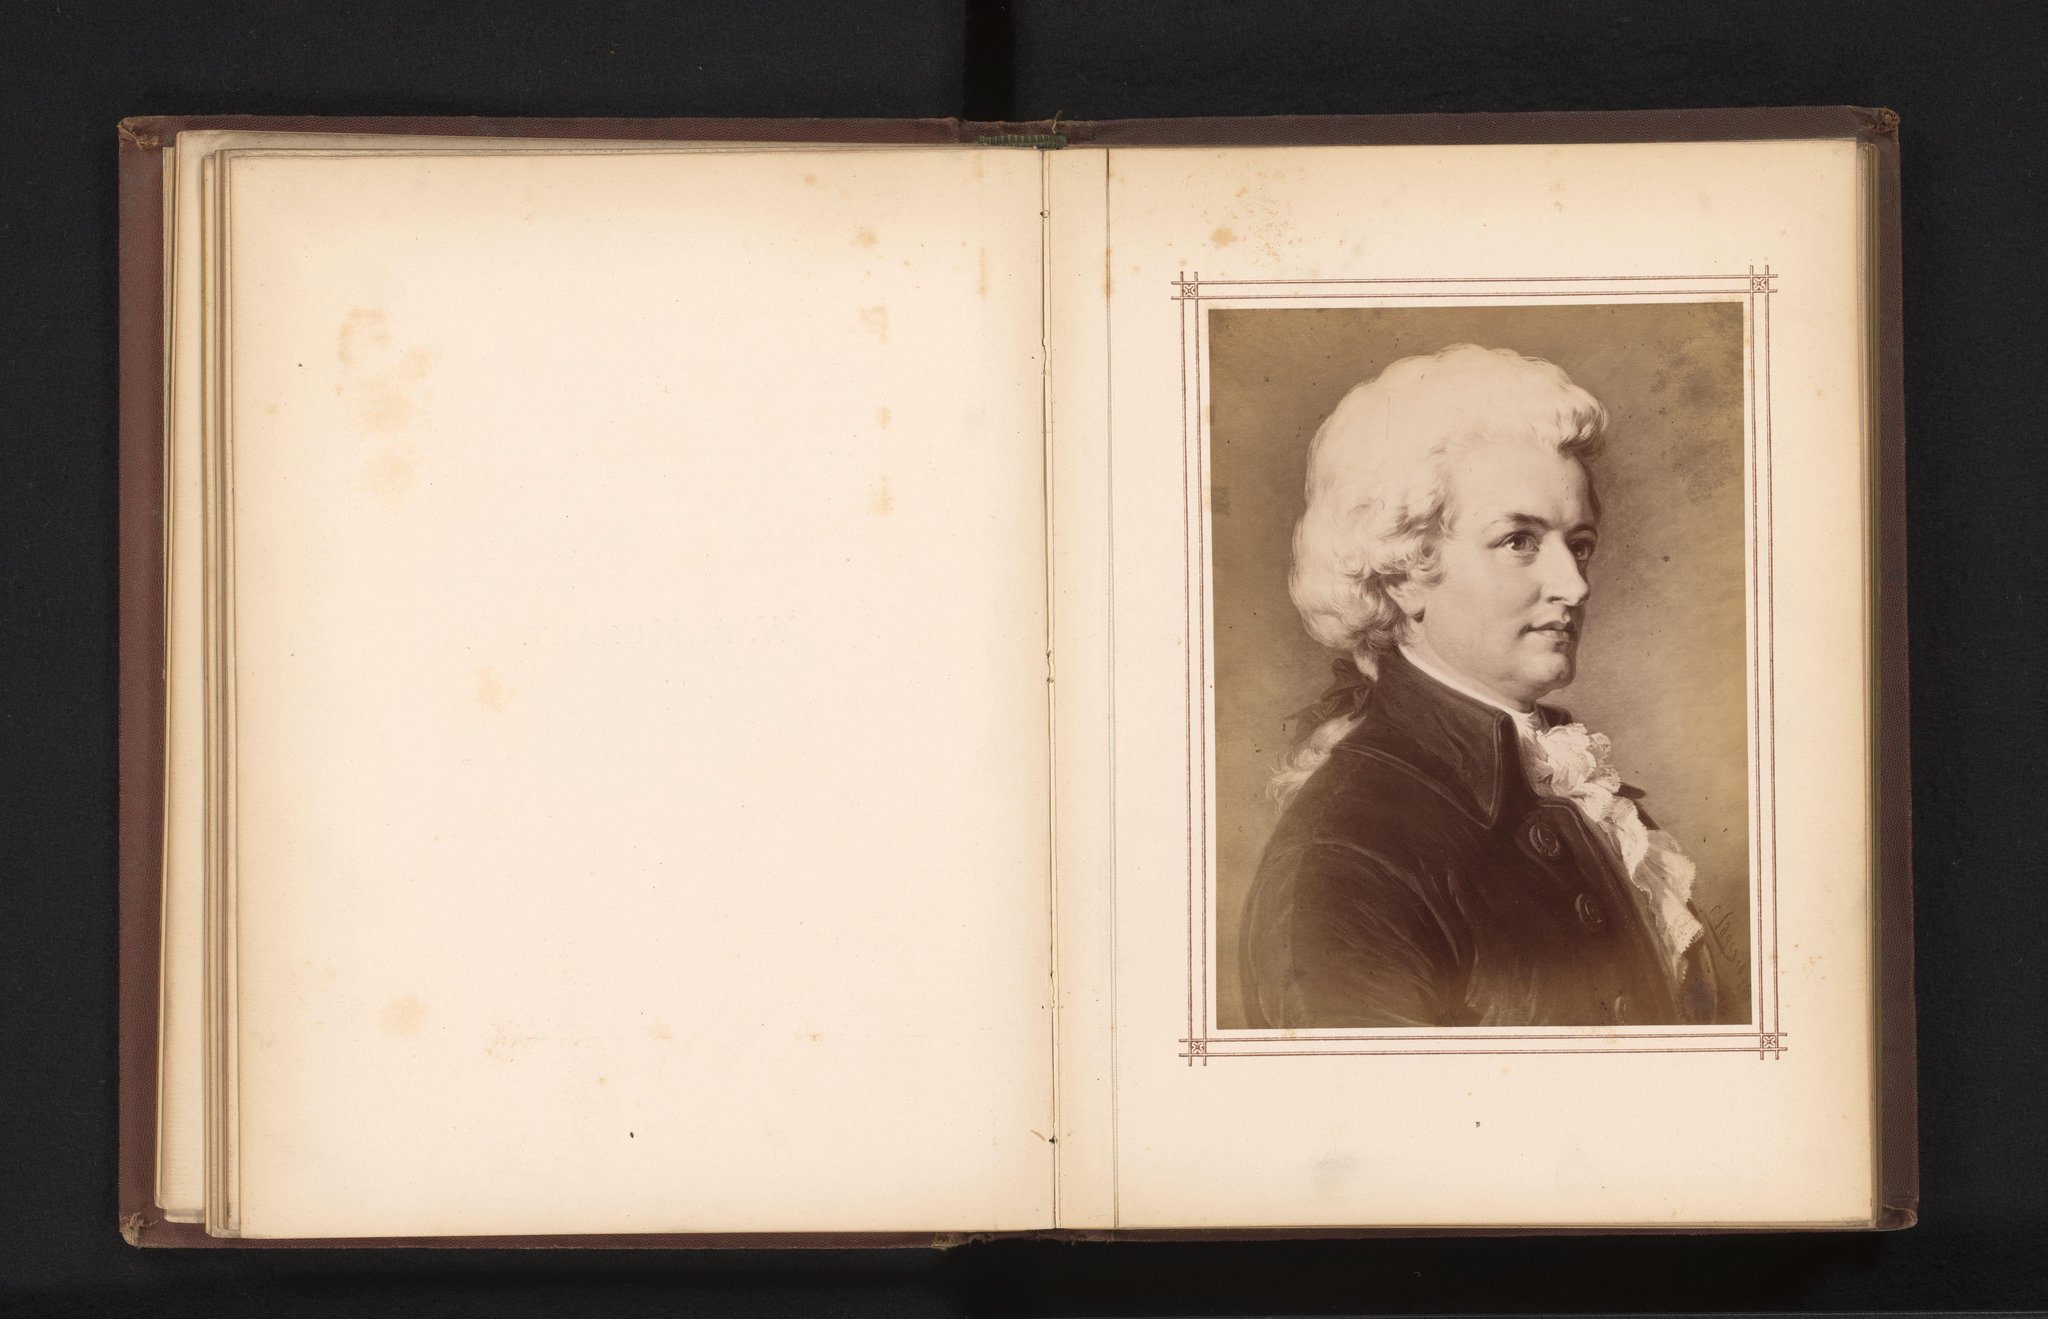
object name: page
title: Fotoreproductie van een portret van Wolfgang Amadeus Mozart door Carl Jaeger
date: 1865-1875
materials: photographic support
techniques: albumen print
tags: vienna, composer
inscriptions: name: ‘C. Jäger 1870’